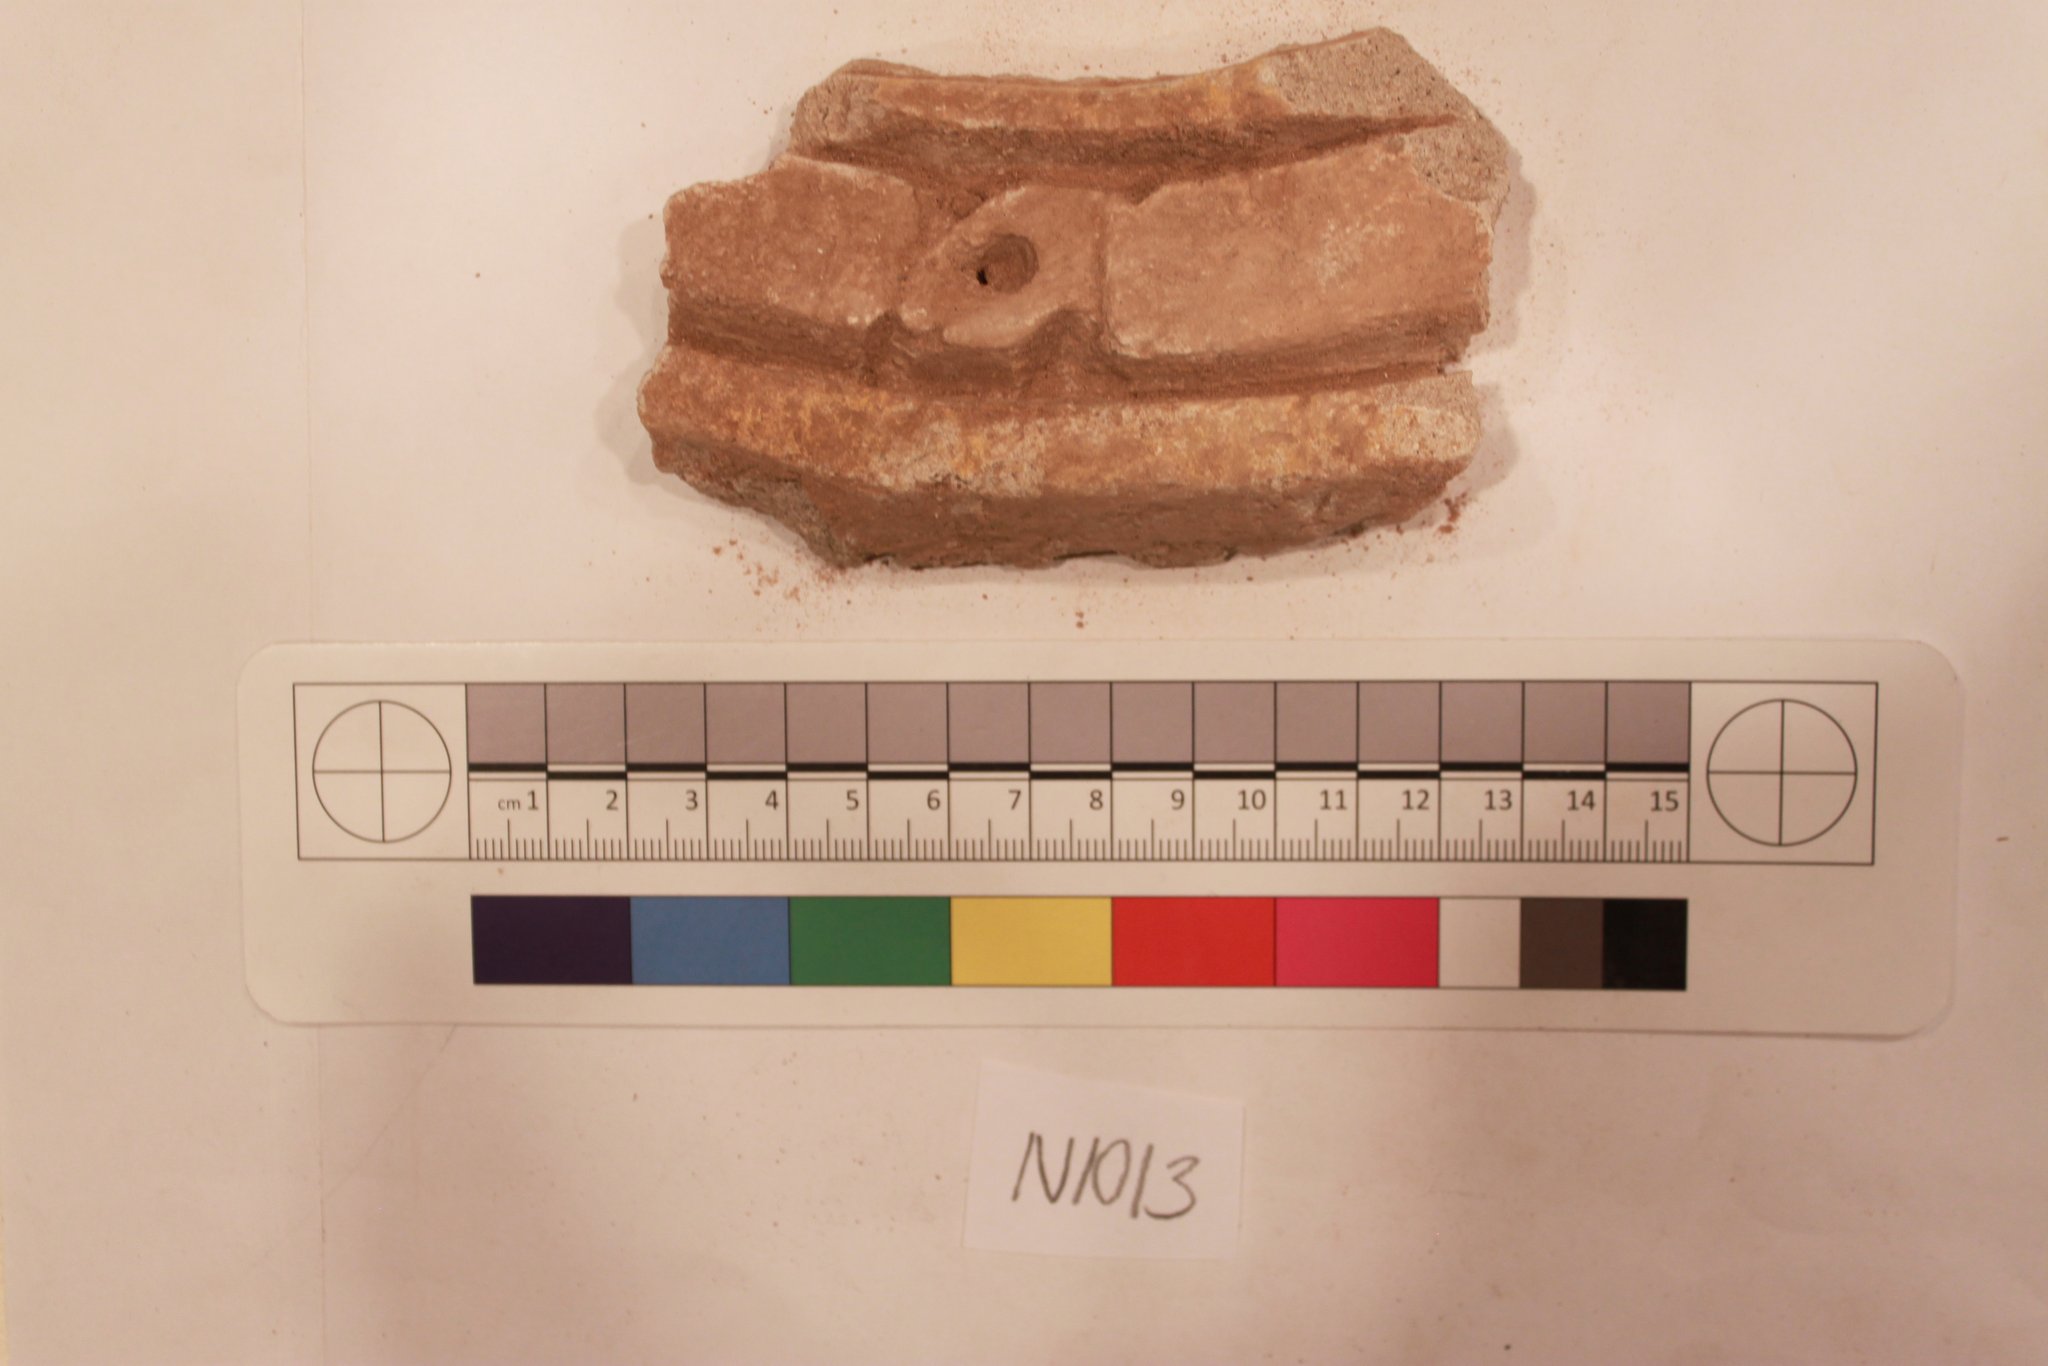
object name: fragment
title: Stucco Fragment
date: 701-1200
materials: plaster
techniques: carving, painting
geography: iran